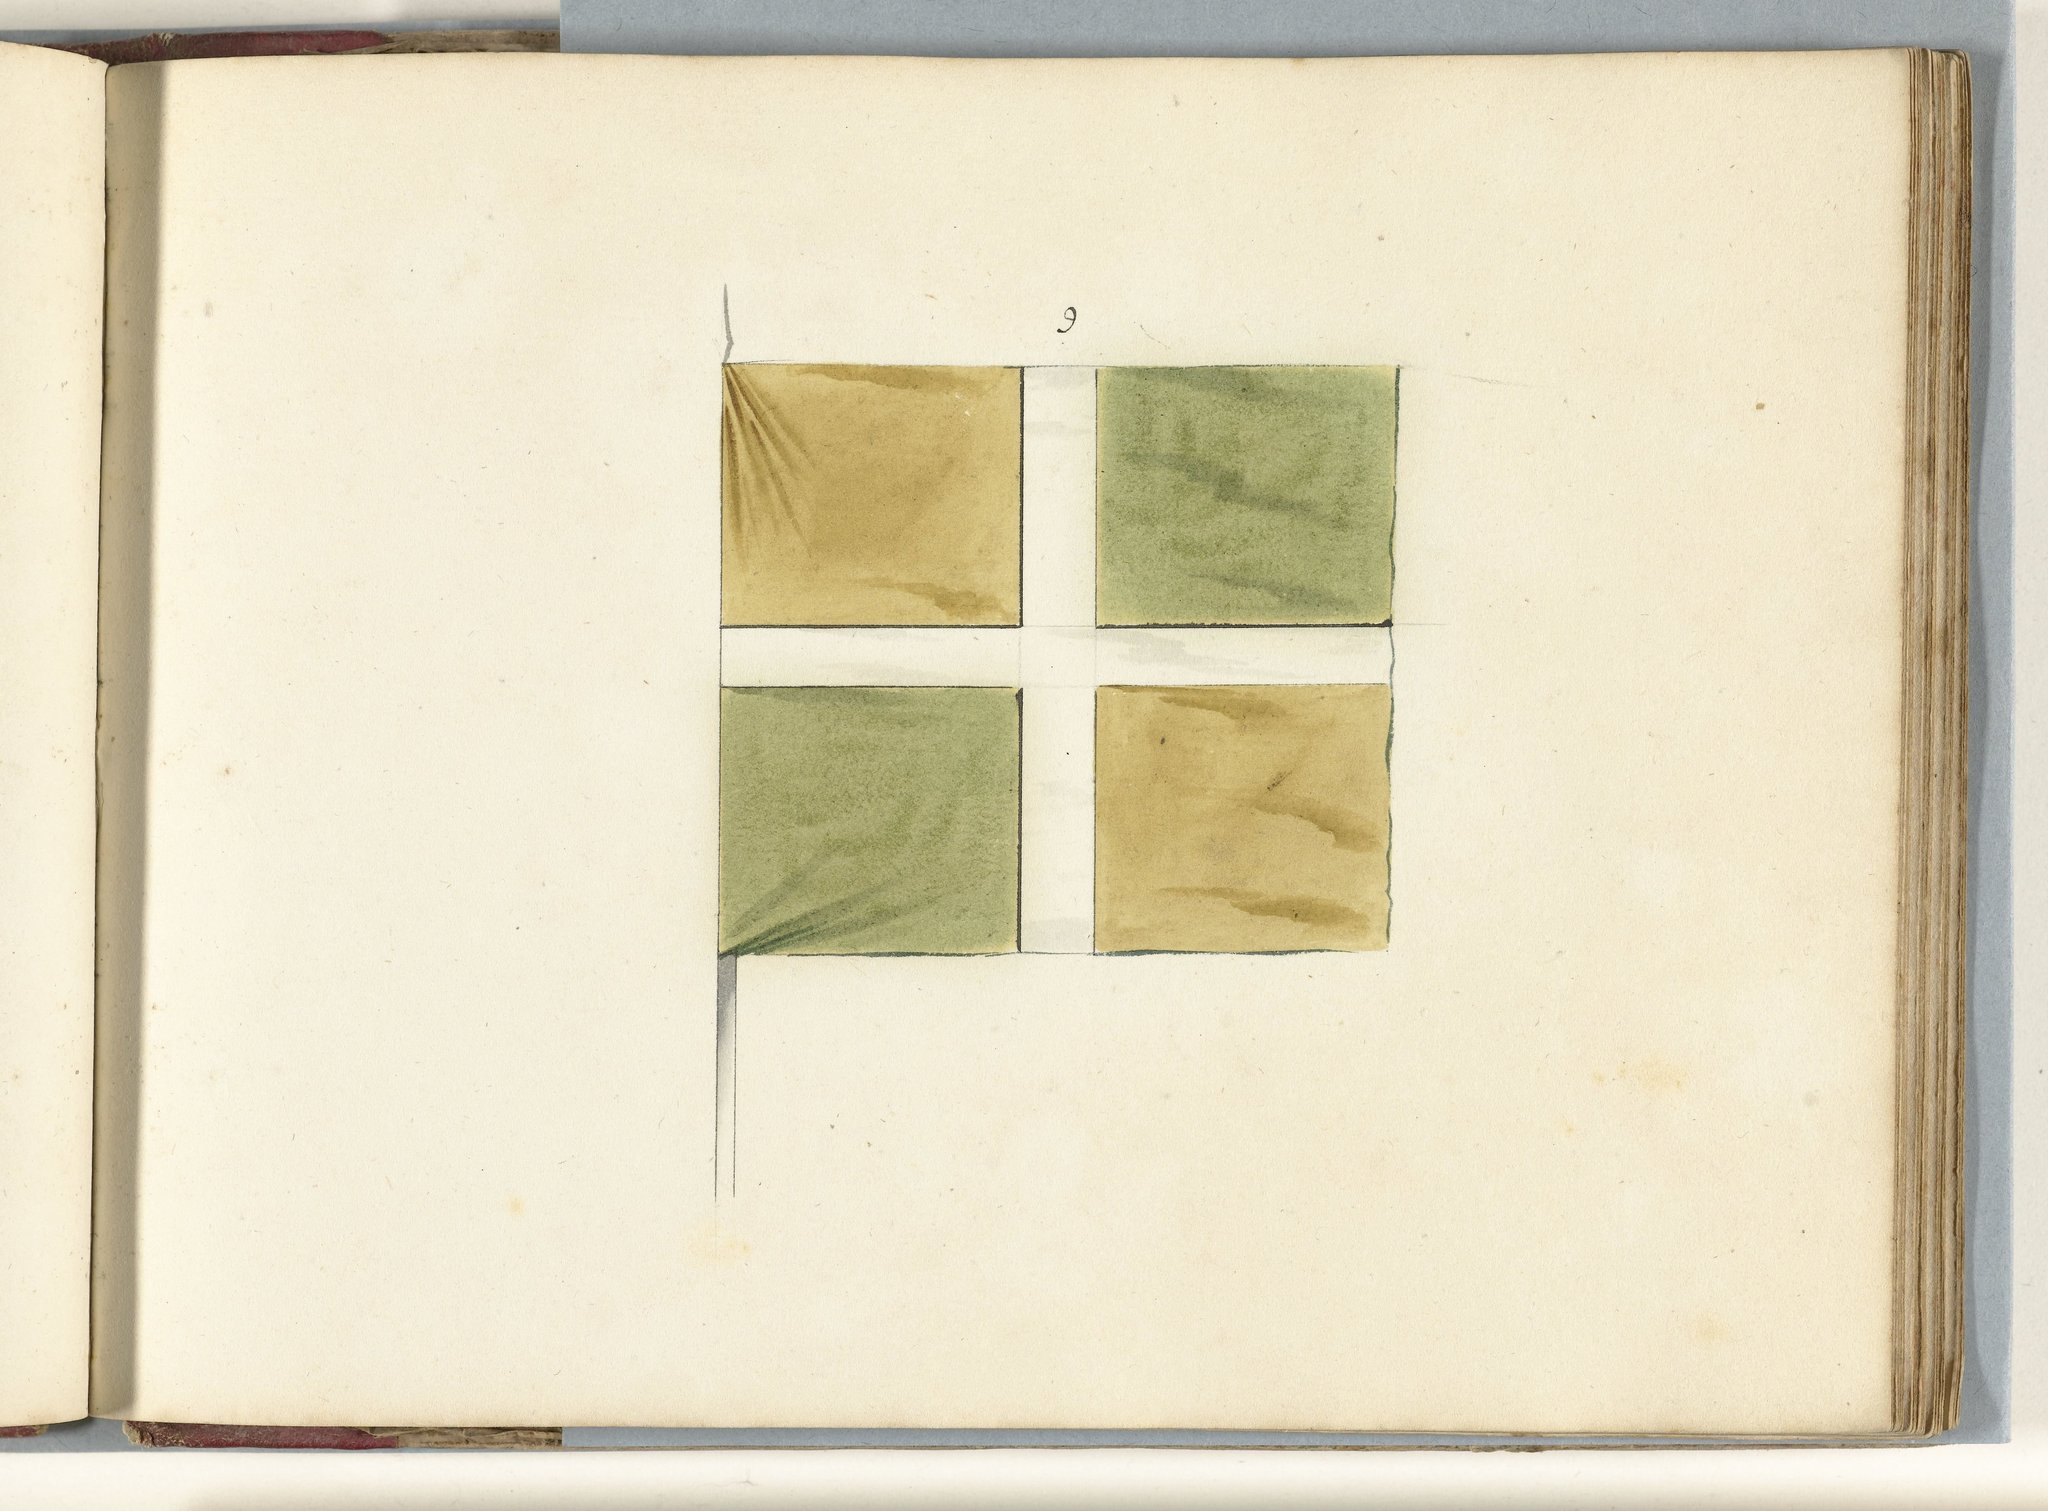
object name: drawing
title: Frans vaandel veroverd in de slag bij Malplaquet, 1709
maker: Anonymous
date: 1713-1720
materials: paper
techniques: drawing, writing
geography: northern netherlands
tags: (military) flags and standards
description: Frans vaandel veroverd bij de slag bij Malplaquet in 1709. In het boek met tekeningen van Franse vaandels, standaarden en pauken, veroverd tijdens de Spaanse Successieoorlog (1701-1713).